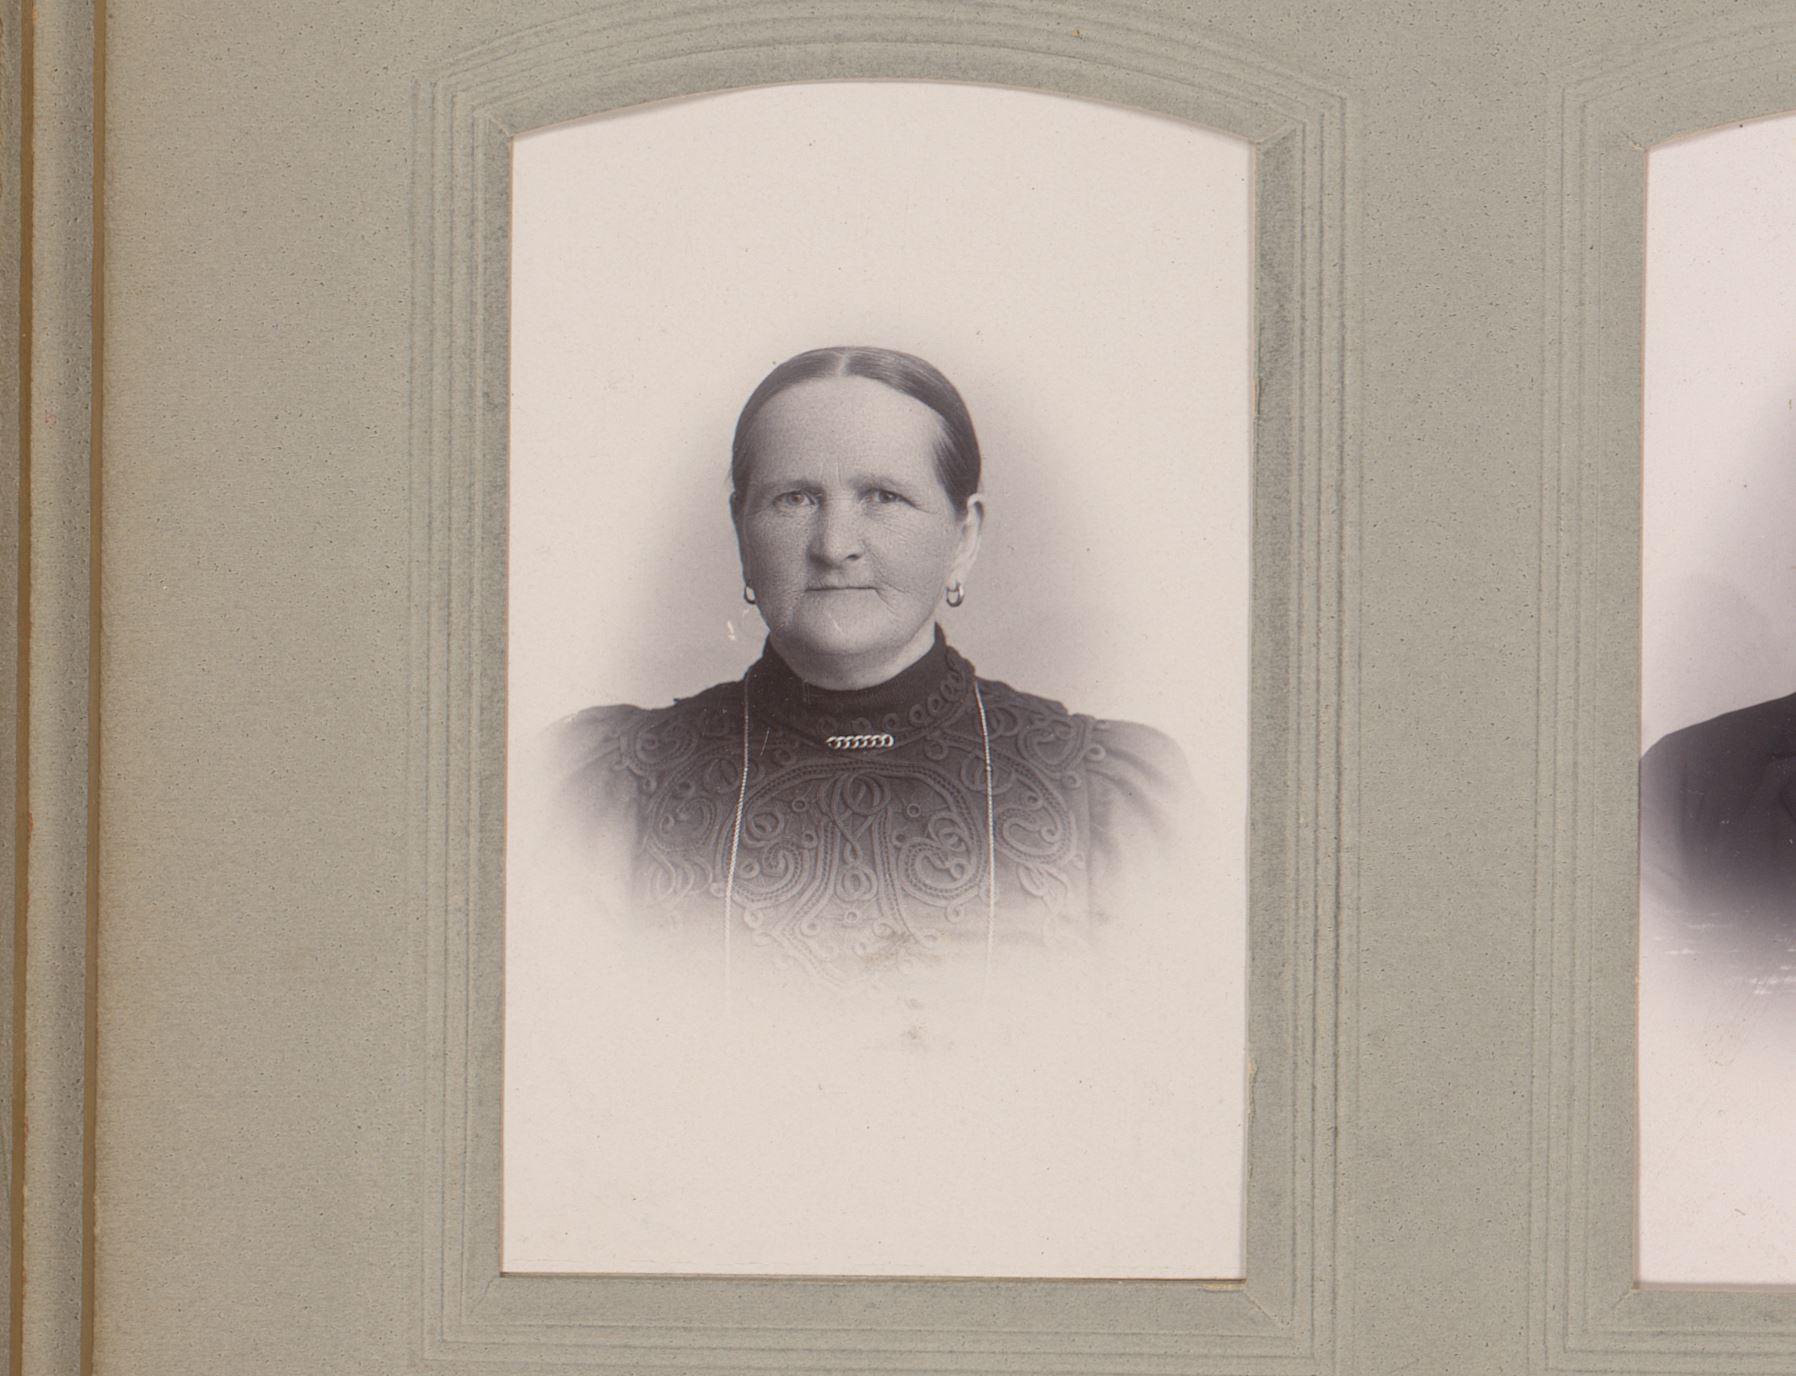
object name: album leaf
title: Portret van een vrouw met oorbellen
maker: hedvig rosendahl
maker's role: fotograaf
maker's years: 1867-1929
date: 1880-1920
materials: cardboard, photographic support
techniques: collodion silver print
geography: stockholm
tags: historical persons - bb - woman, ear-rings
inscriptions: inscription: ‘Hedvig Rosendahls/ Atelier/ Stockholm/ Allm. Telef./ 42/ 10778/ Drotninggatan/ Allm. Telef./ & 51/ 11087/ Malmskilnadsgatan 48 c/ Allm. Tel. 6290./ Plåten förvaras för efterbeställning.’